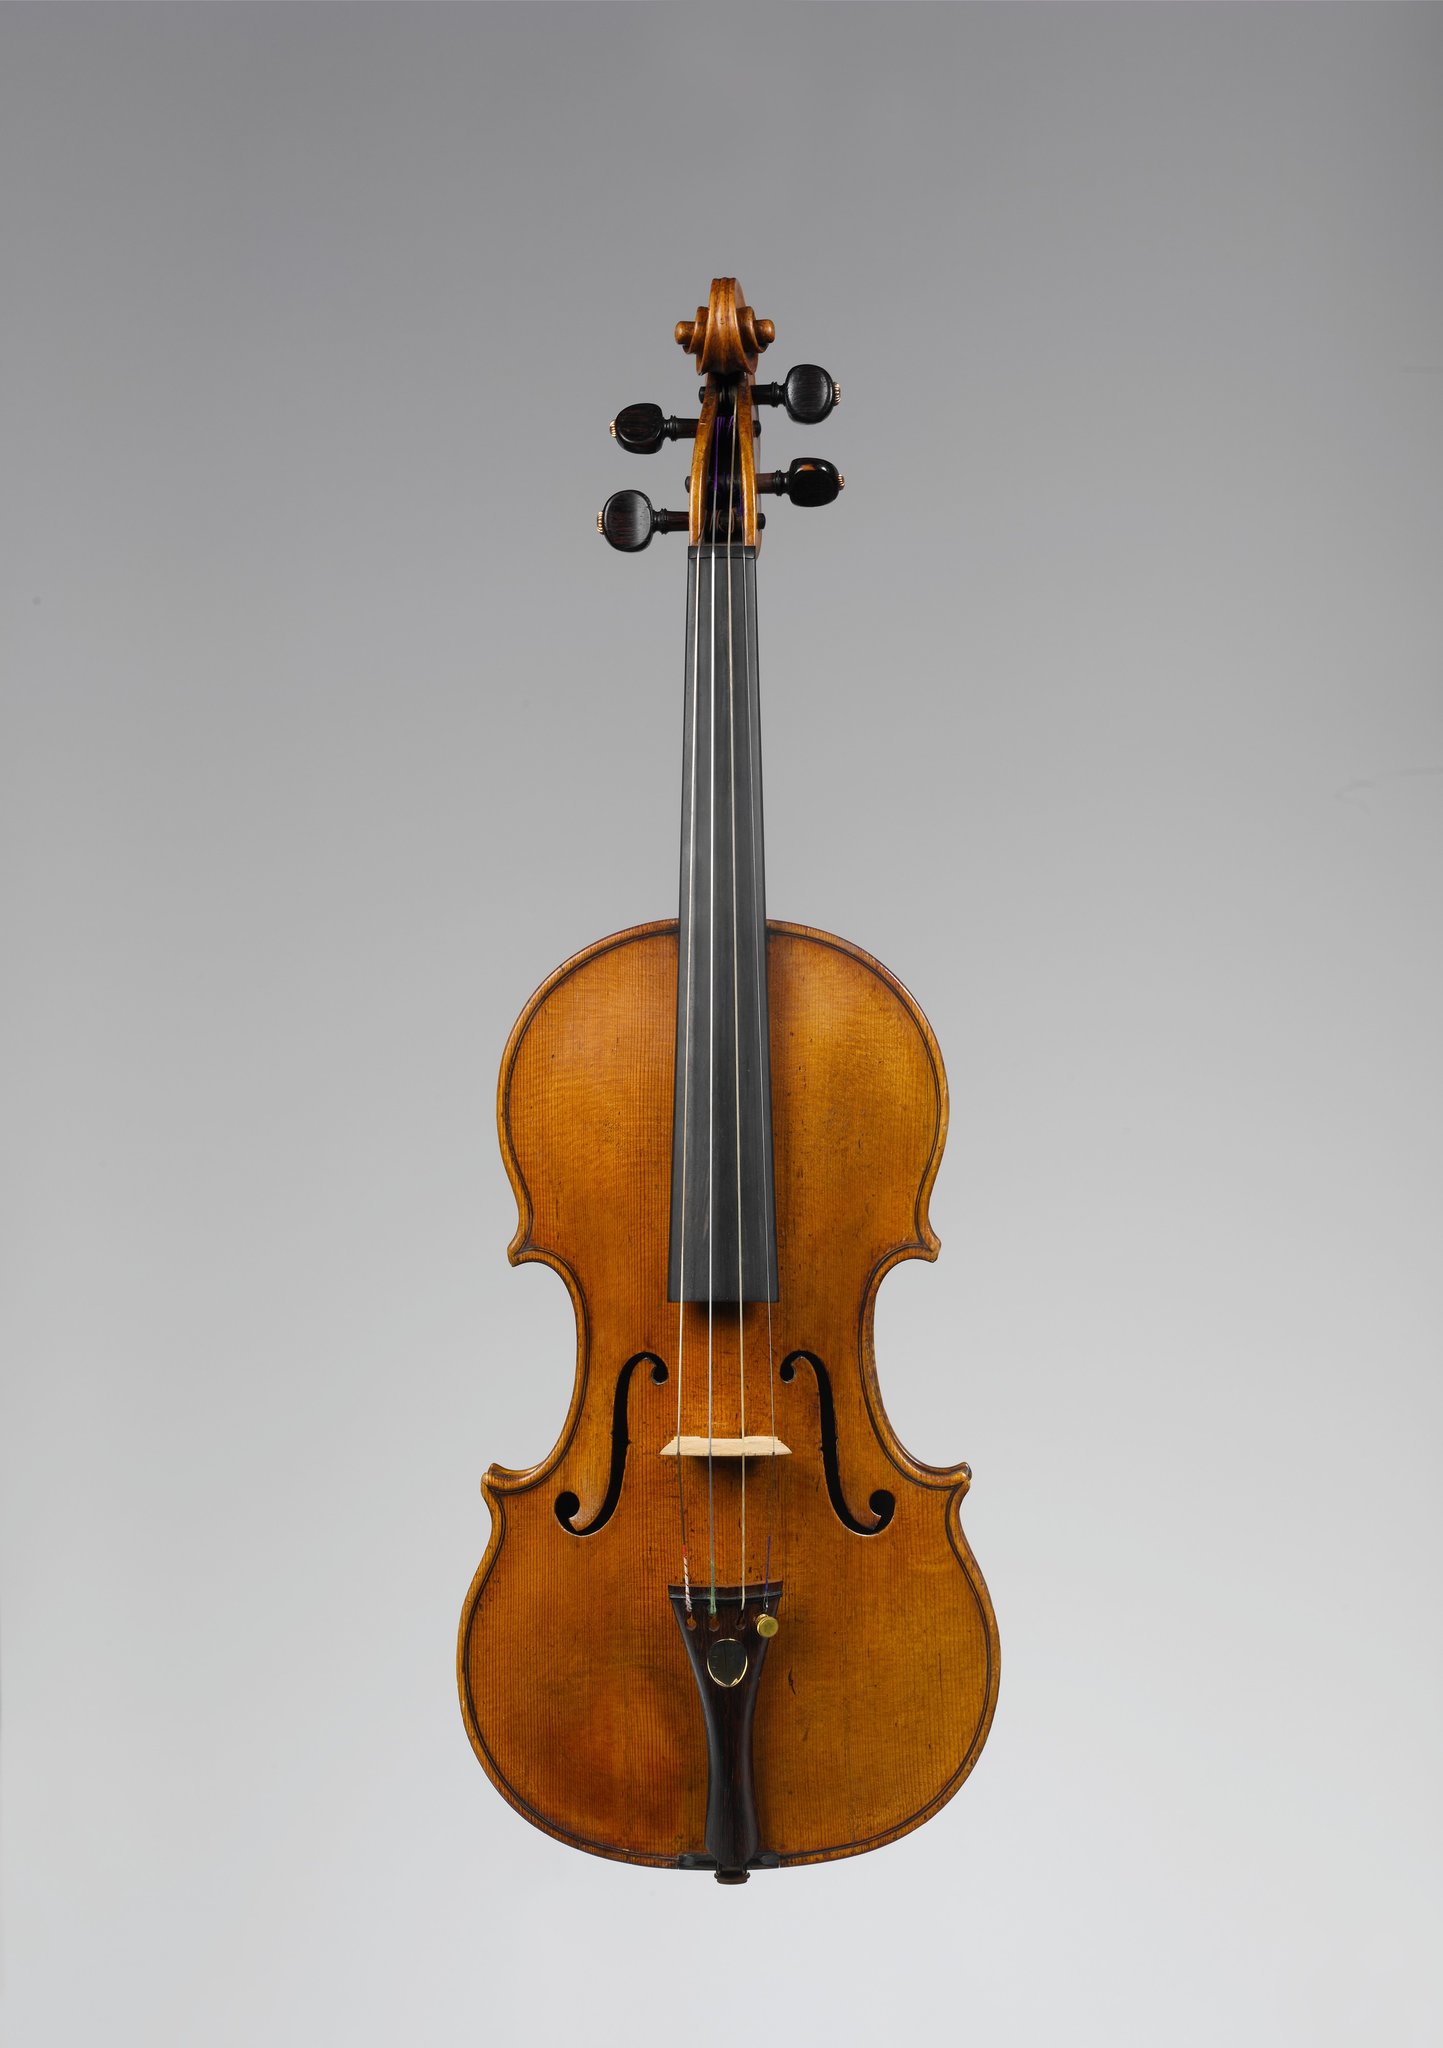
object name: violin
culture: italian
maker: antonio gragnani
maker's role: maker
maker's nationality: italian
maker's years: 1765-1795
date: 1783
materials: wood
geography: italy